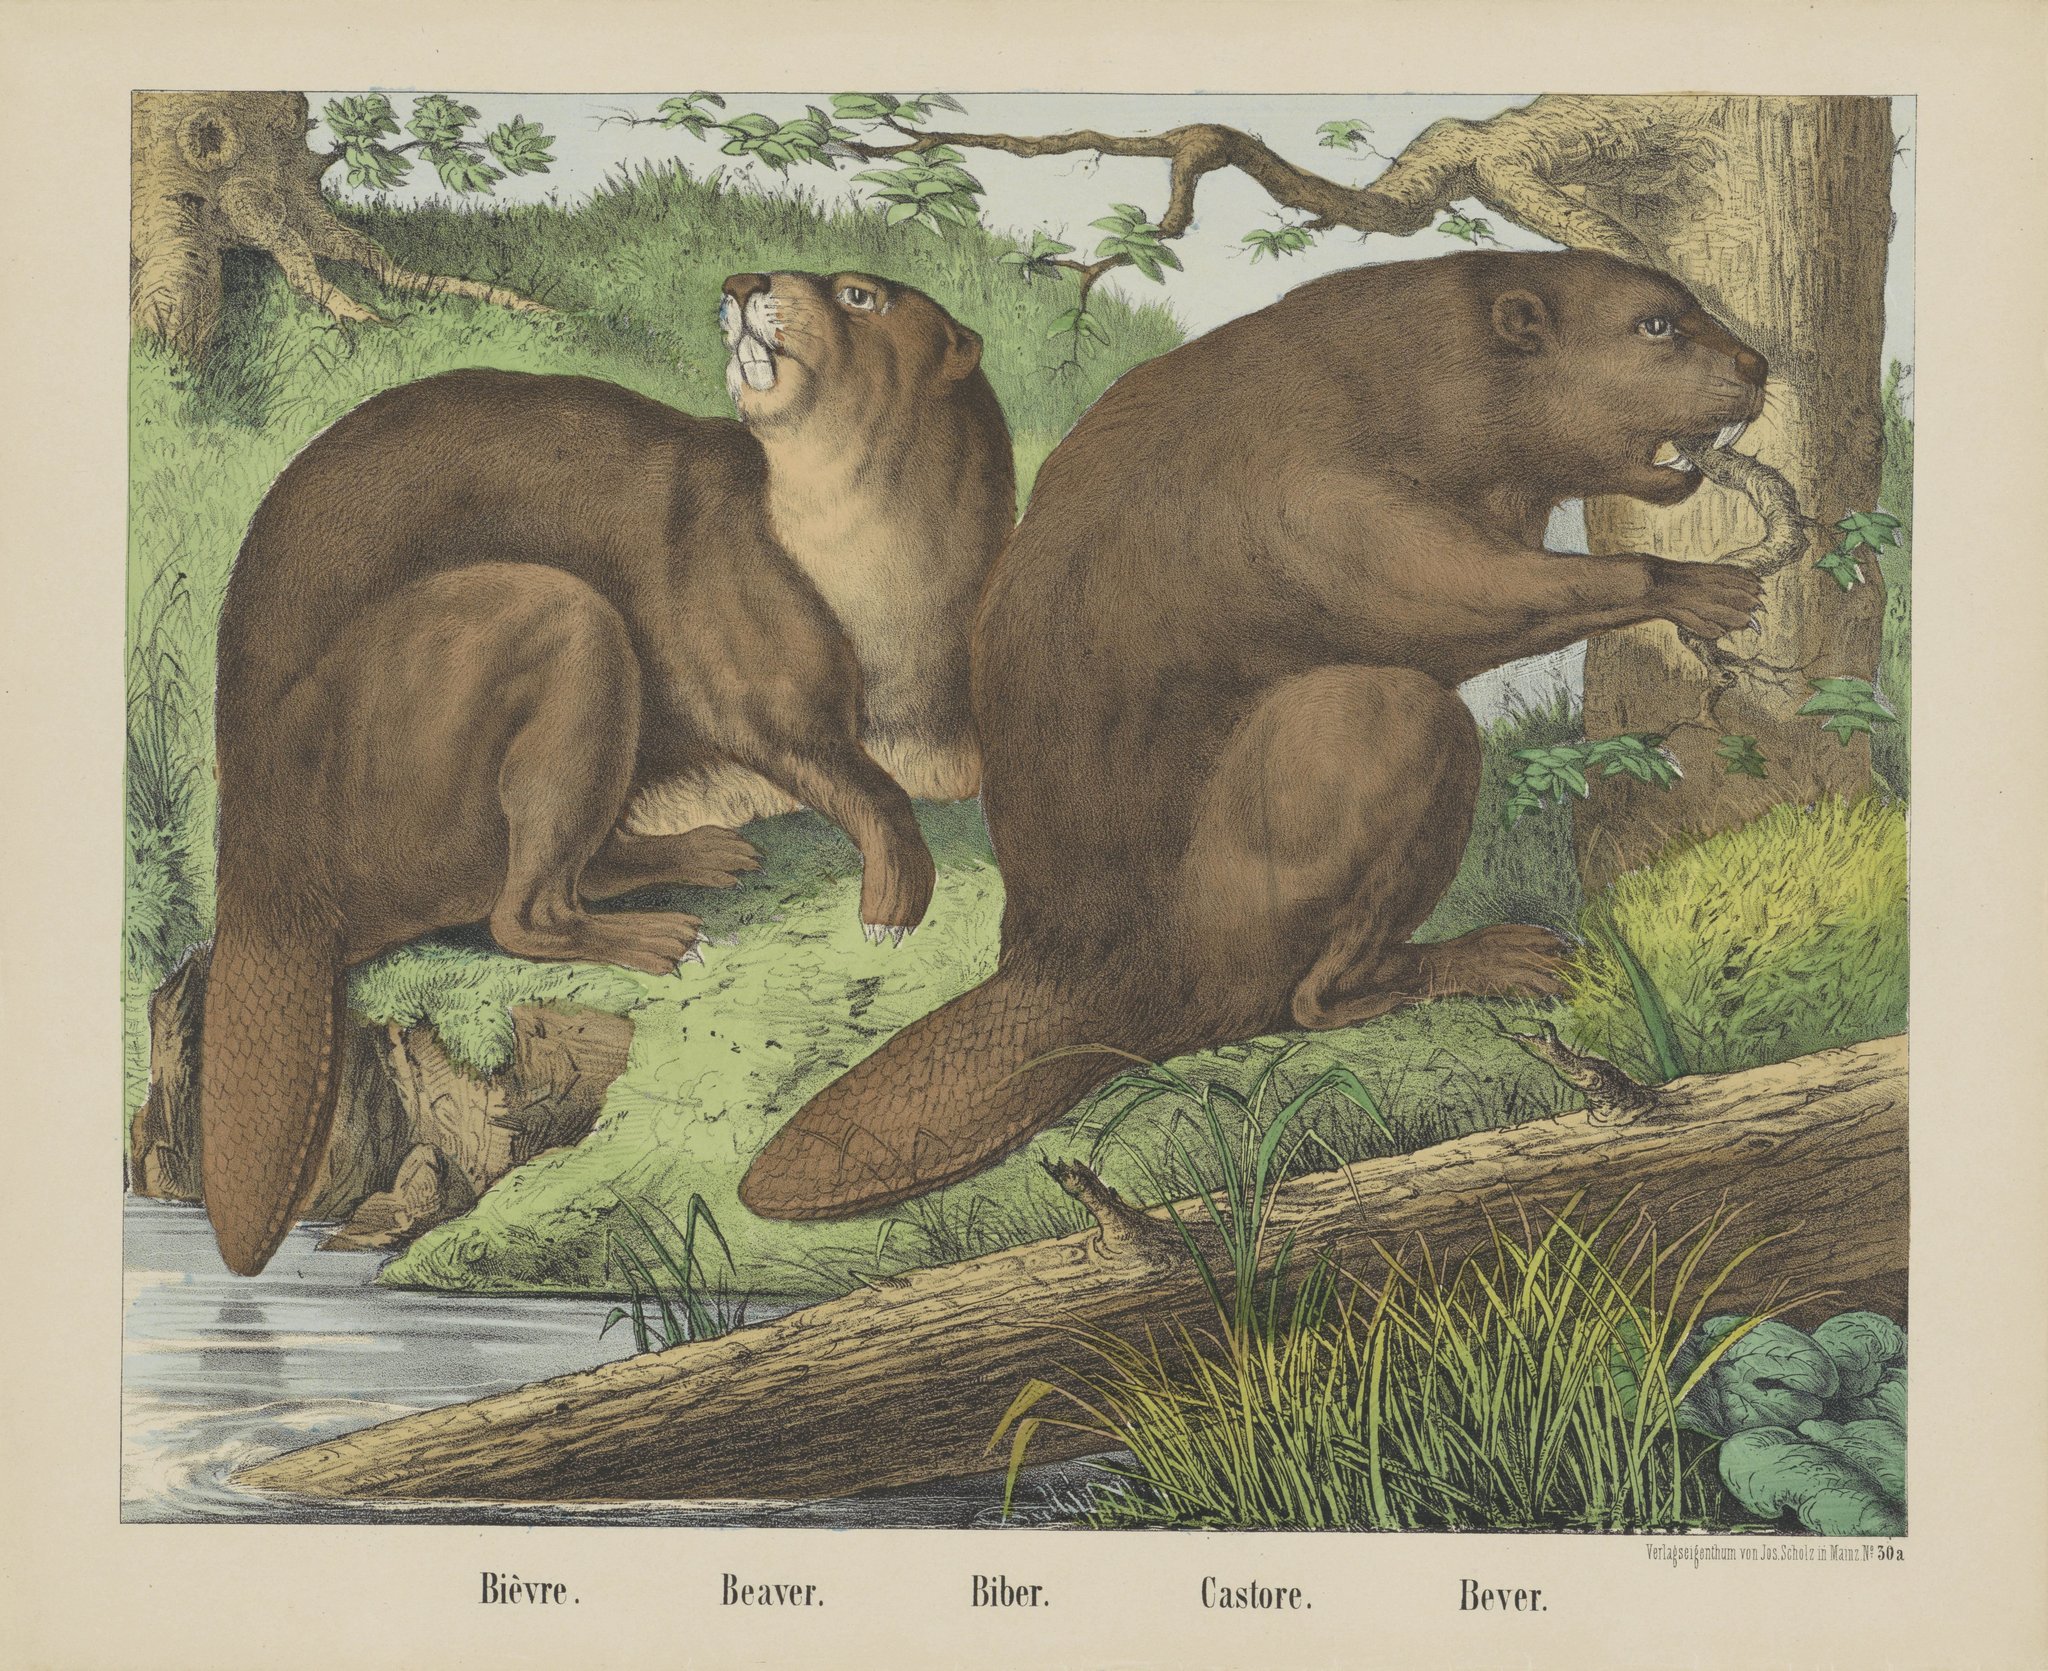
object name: popular print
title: Bièvre. / Beaver. / Biber. / Castore. / Bever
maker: Anonymous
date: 1829-1880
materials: paper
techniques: colour, letterpress printing, lithograph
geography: mainz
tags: rodents: beaver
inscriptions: collector's mark: Lugt 2760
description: Twee bevers aan de waterkant. Genummerd rechtsonder: 30a.